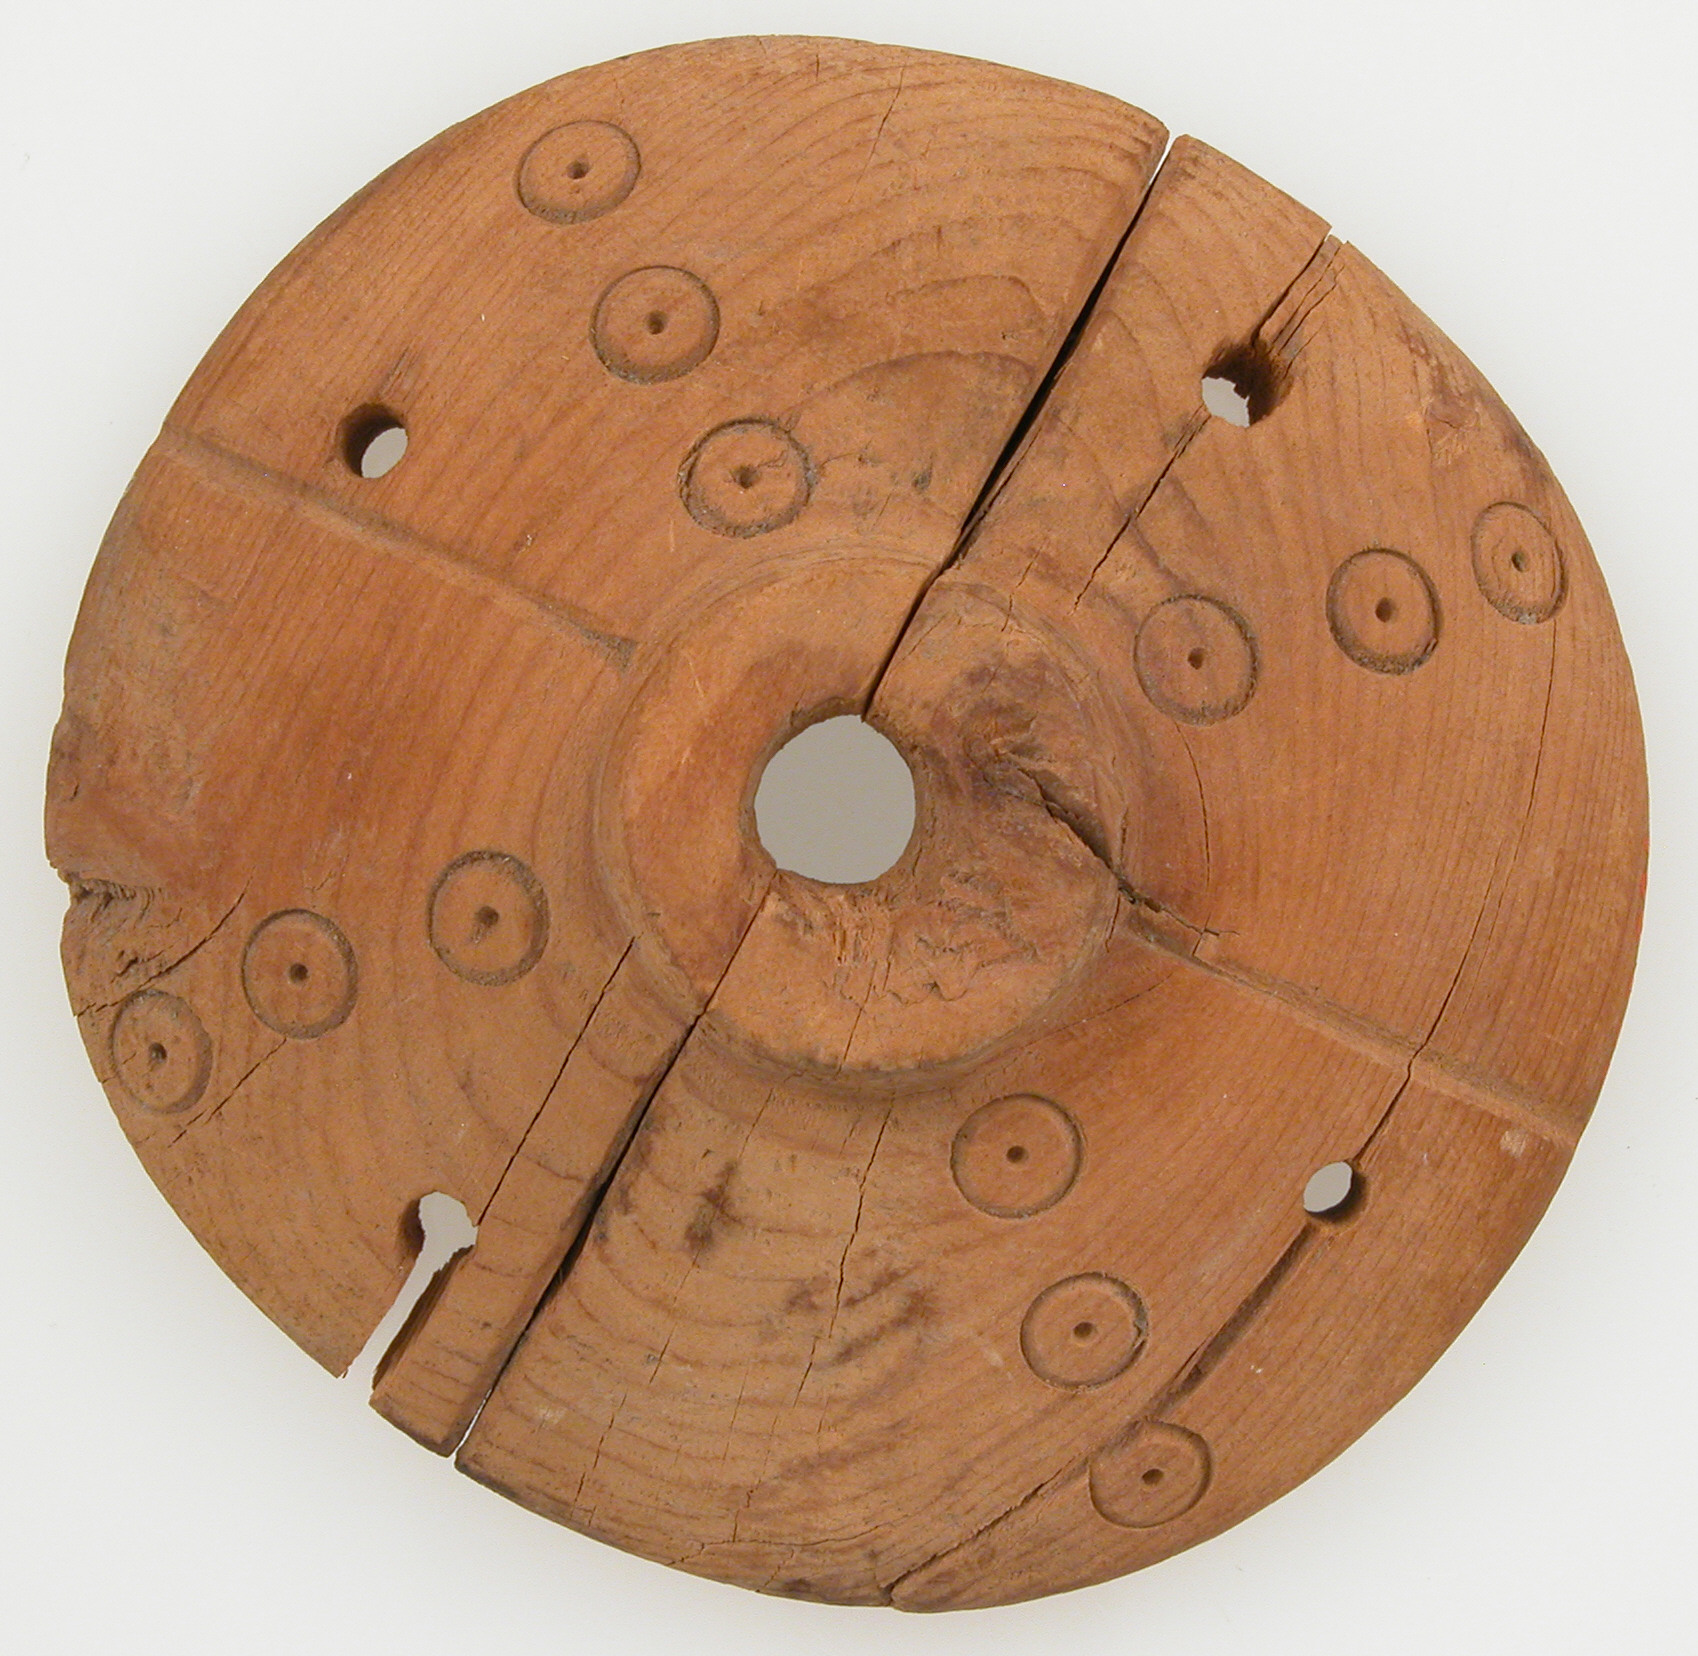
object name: spindle whorl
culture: coptic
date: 201-500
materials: wood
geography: egypt